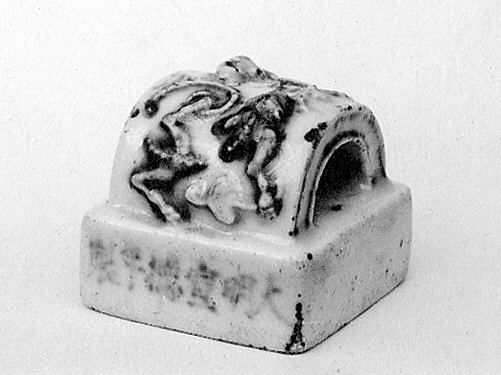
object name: seal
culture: chinese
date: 1426-1435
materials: porcelain